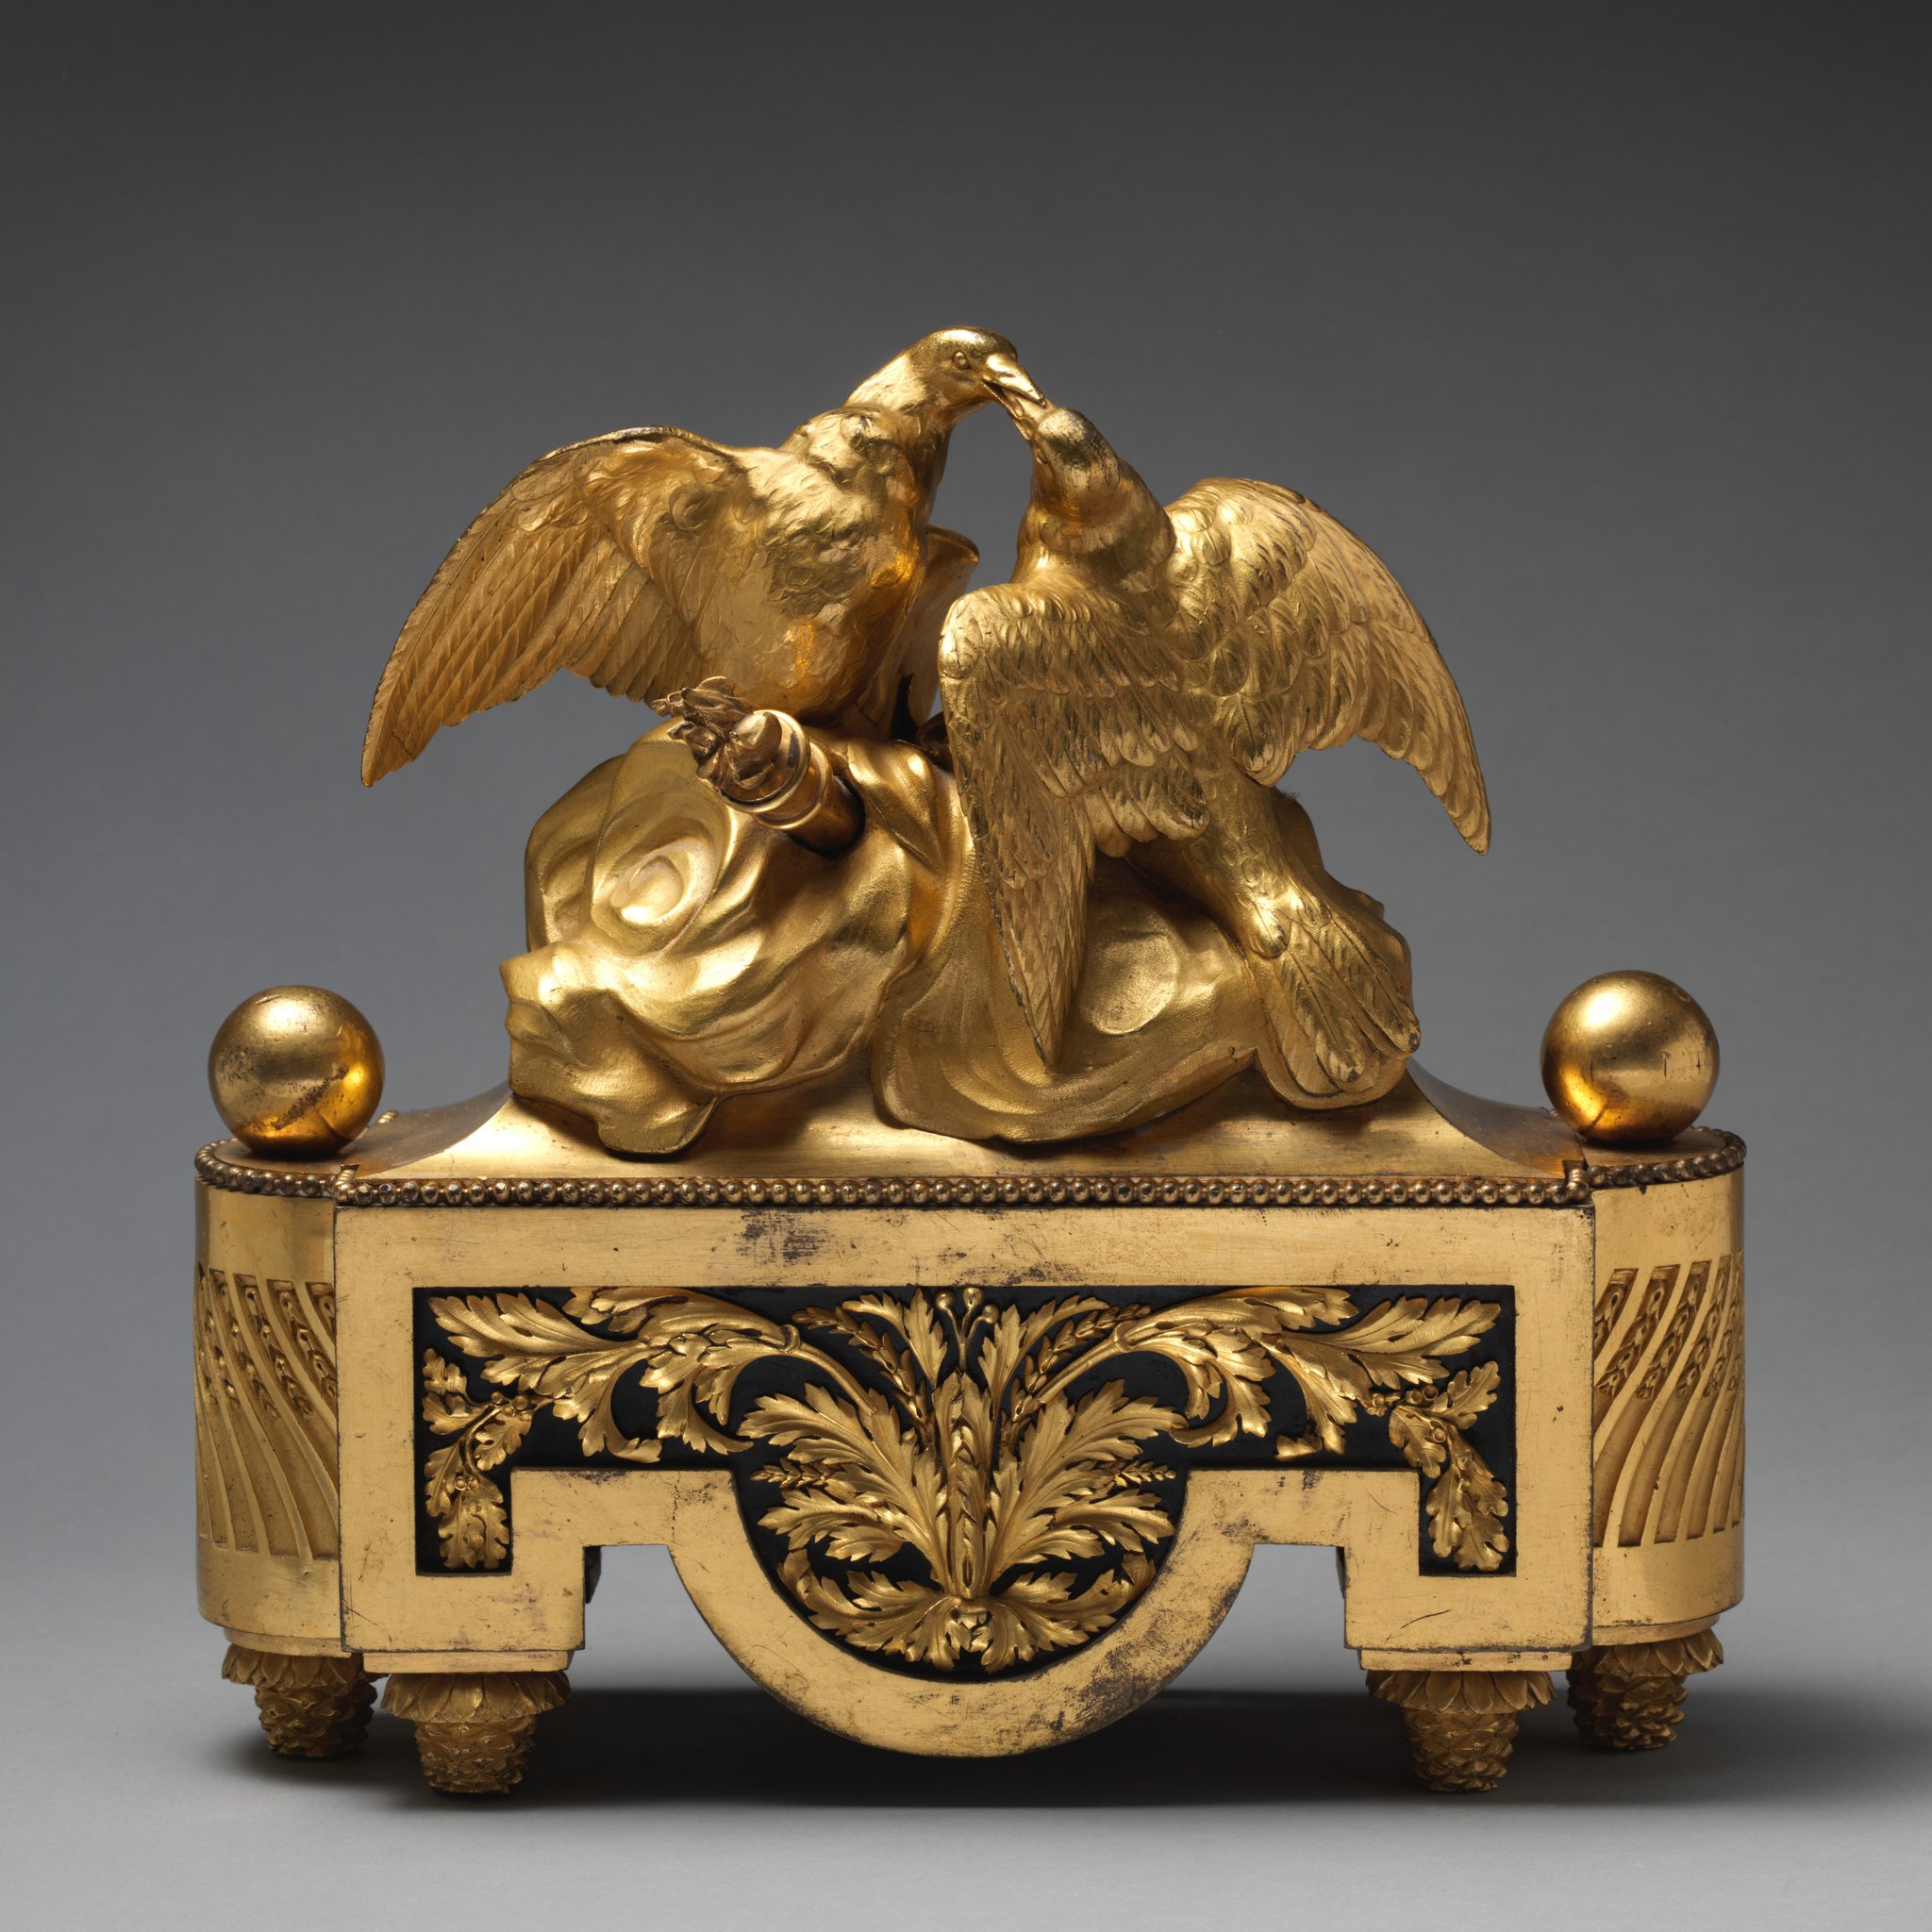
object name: andiron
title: Andiron (feu or chenet) (one of a pair)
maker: françois rémond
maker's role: maker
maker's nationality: french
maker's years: 1747-1812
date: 1780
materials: bronze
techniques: gilding